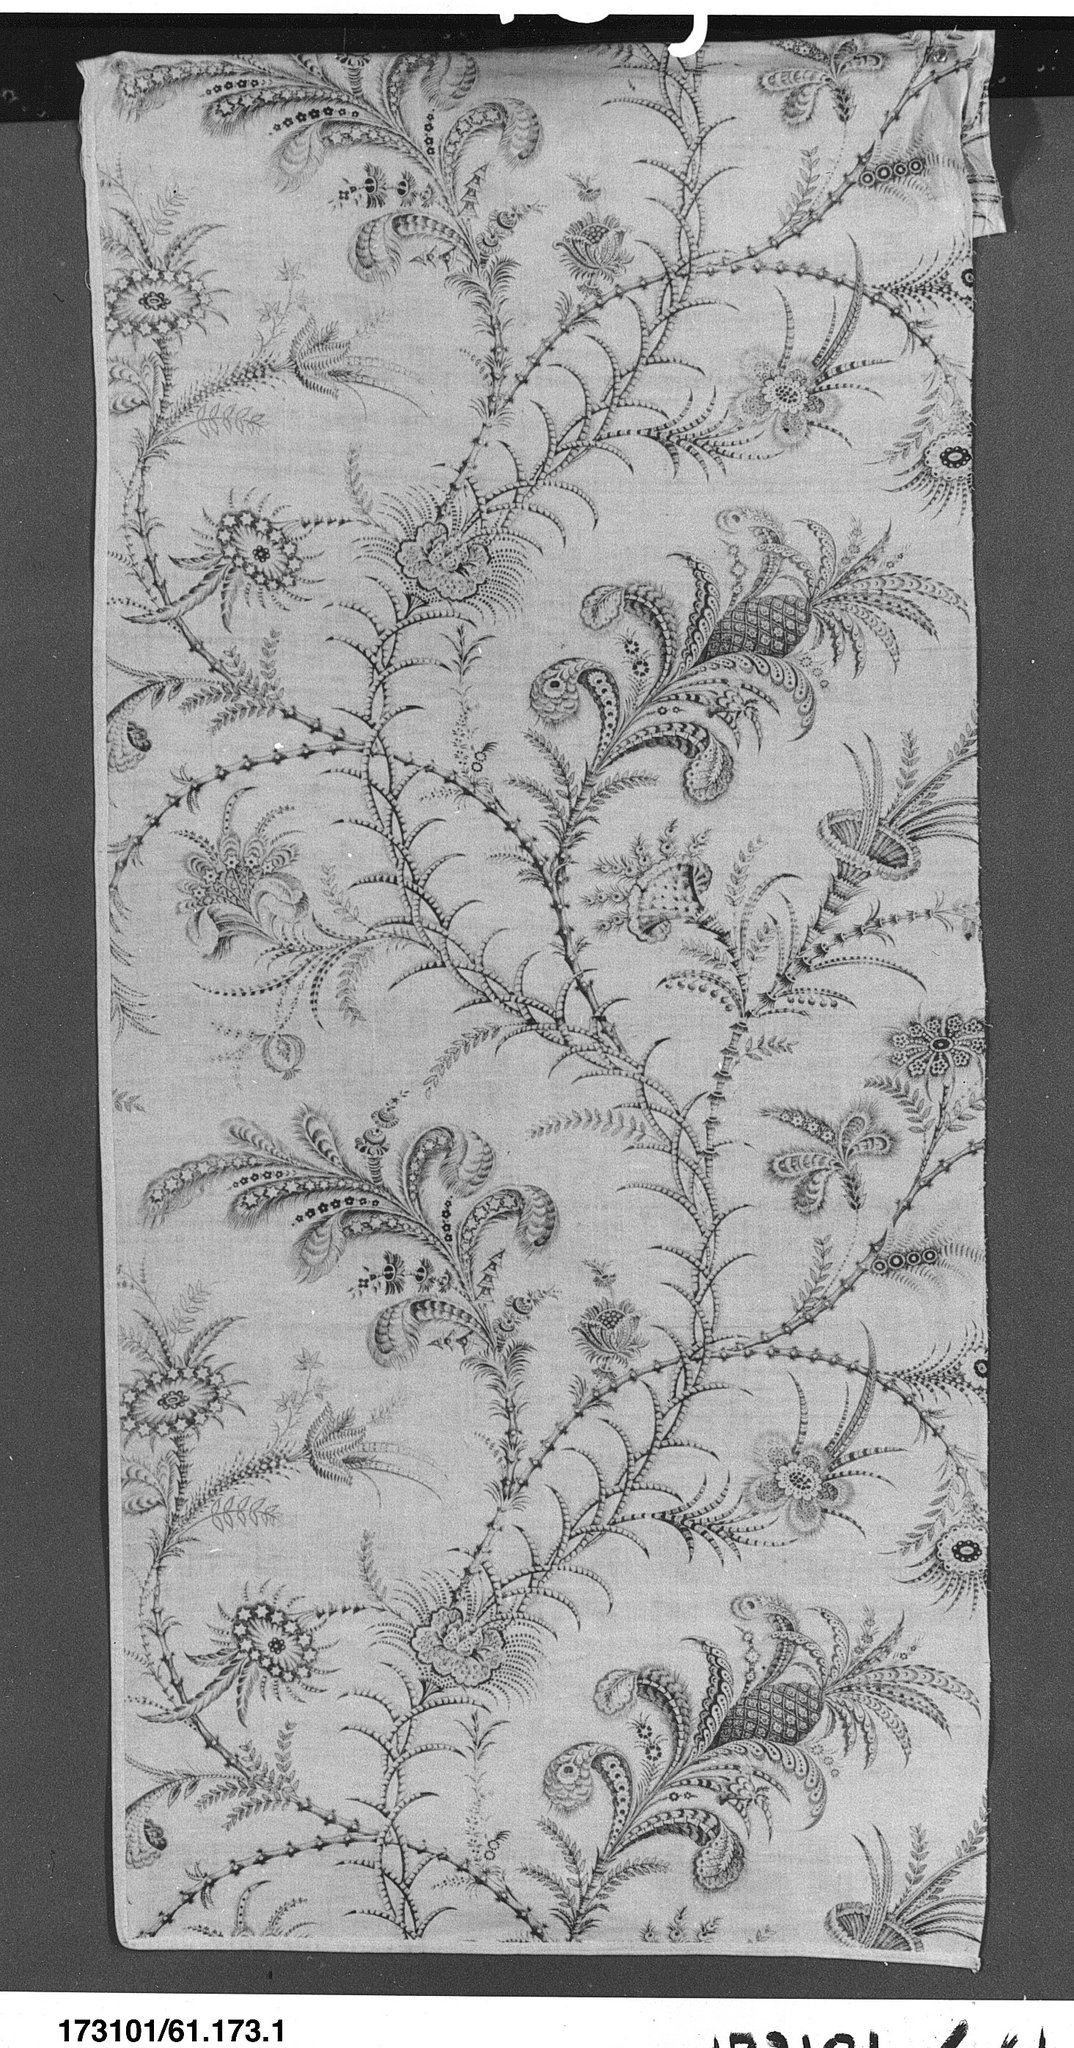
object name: piece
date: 1780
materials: cotton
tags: leaves